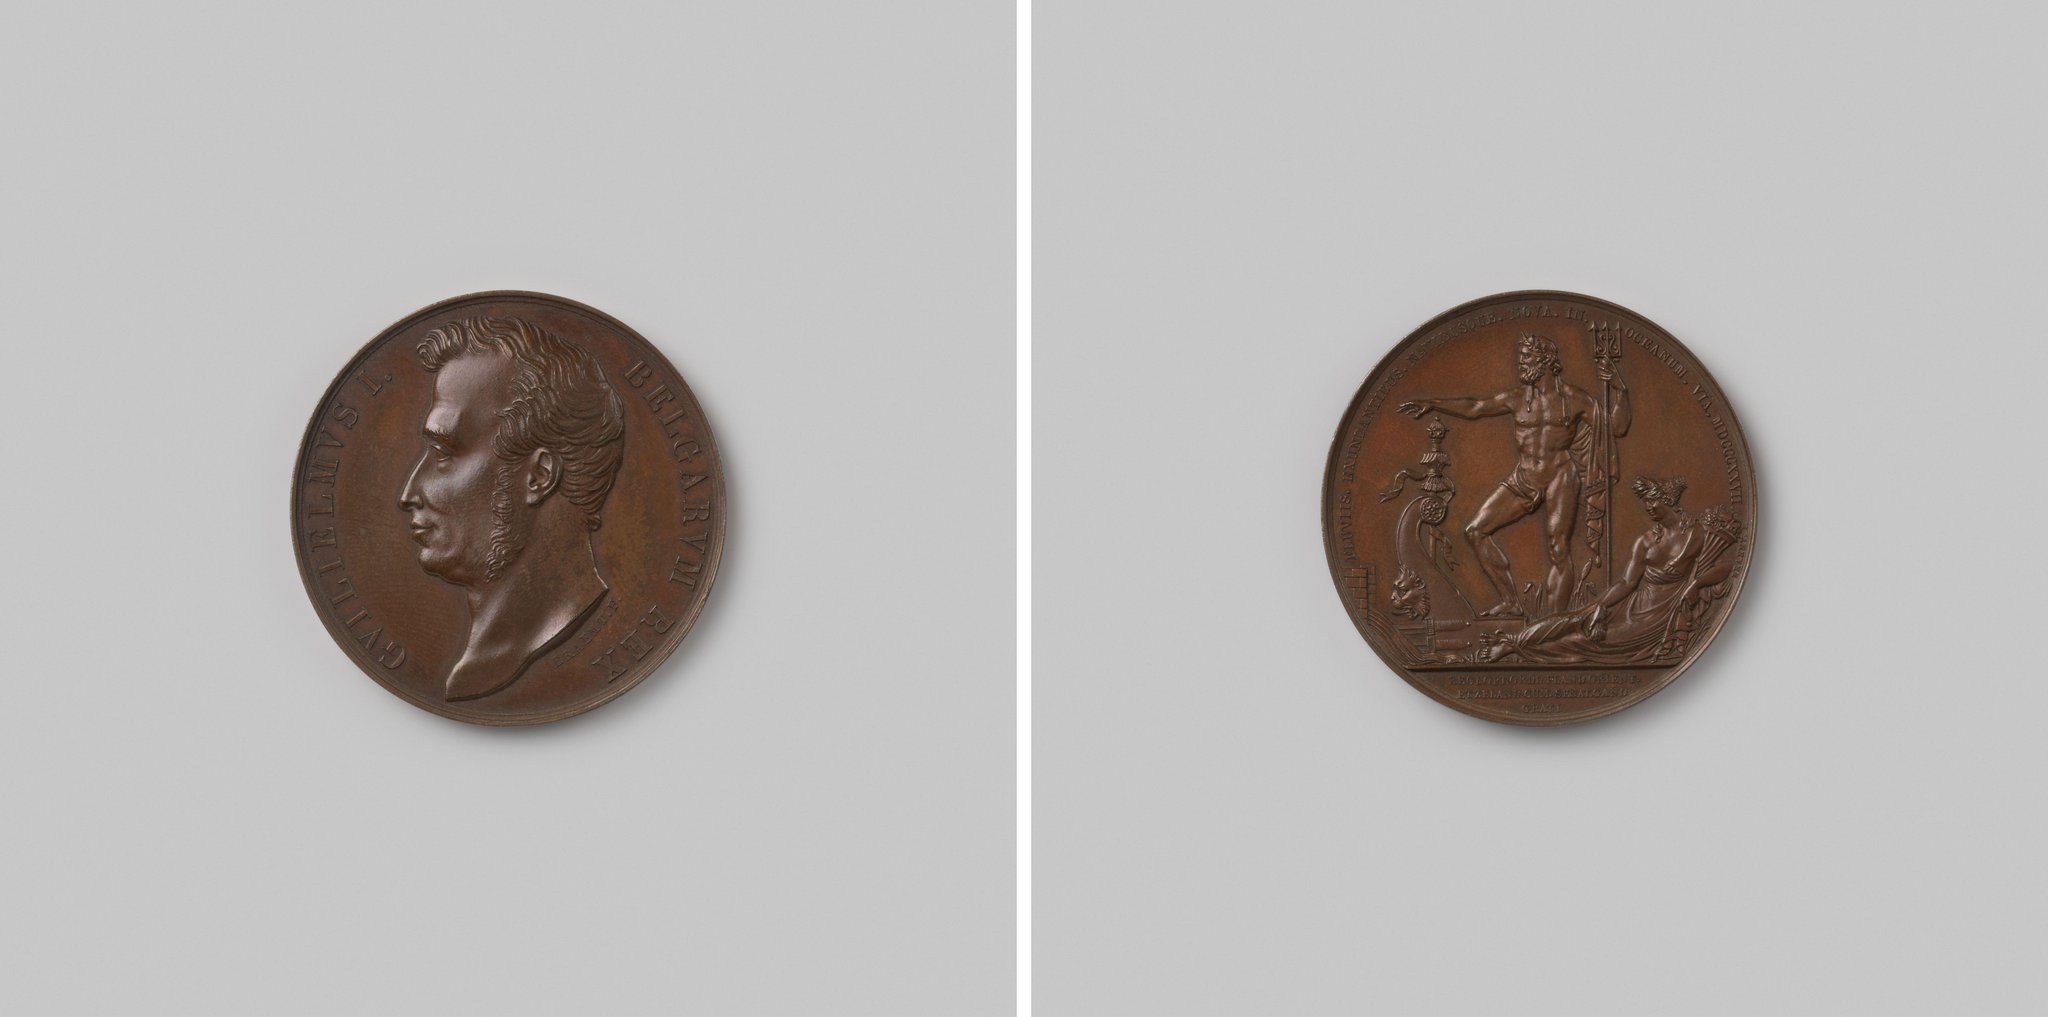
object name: history medal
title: Opening van het Kanaal van Terneuzen naar Gent 1827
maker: joseph pierre braemt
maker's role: print maker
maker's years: 1796-1864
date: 1827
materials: bronze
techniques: striking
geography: brussels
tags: haarlem, the hague, william i of the netherlands, ghent